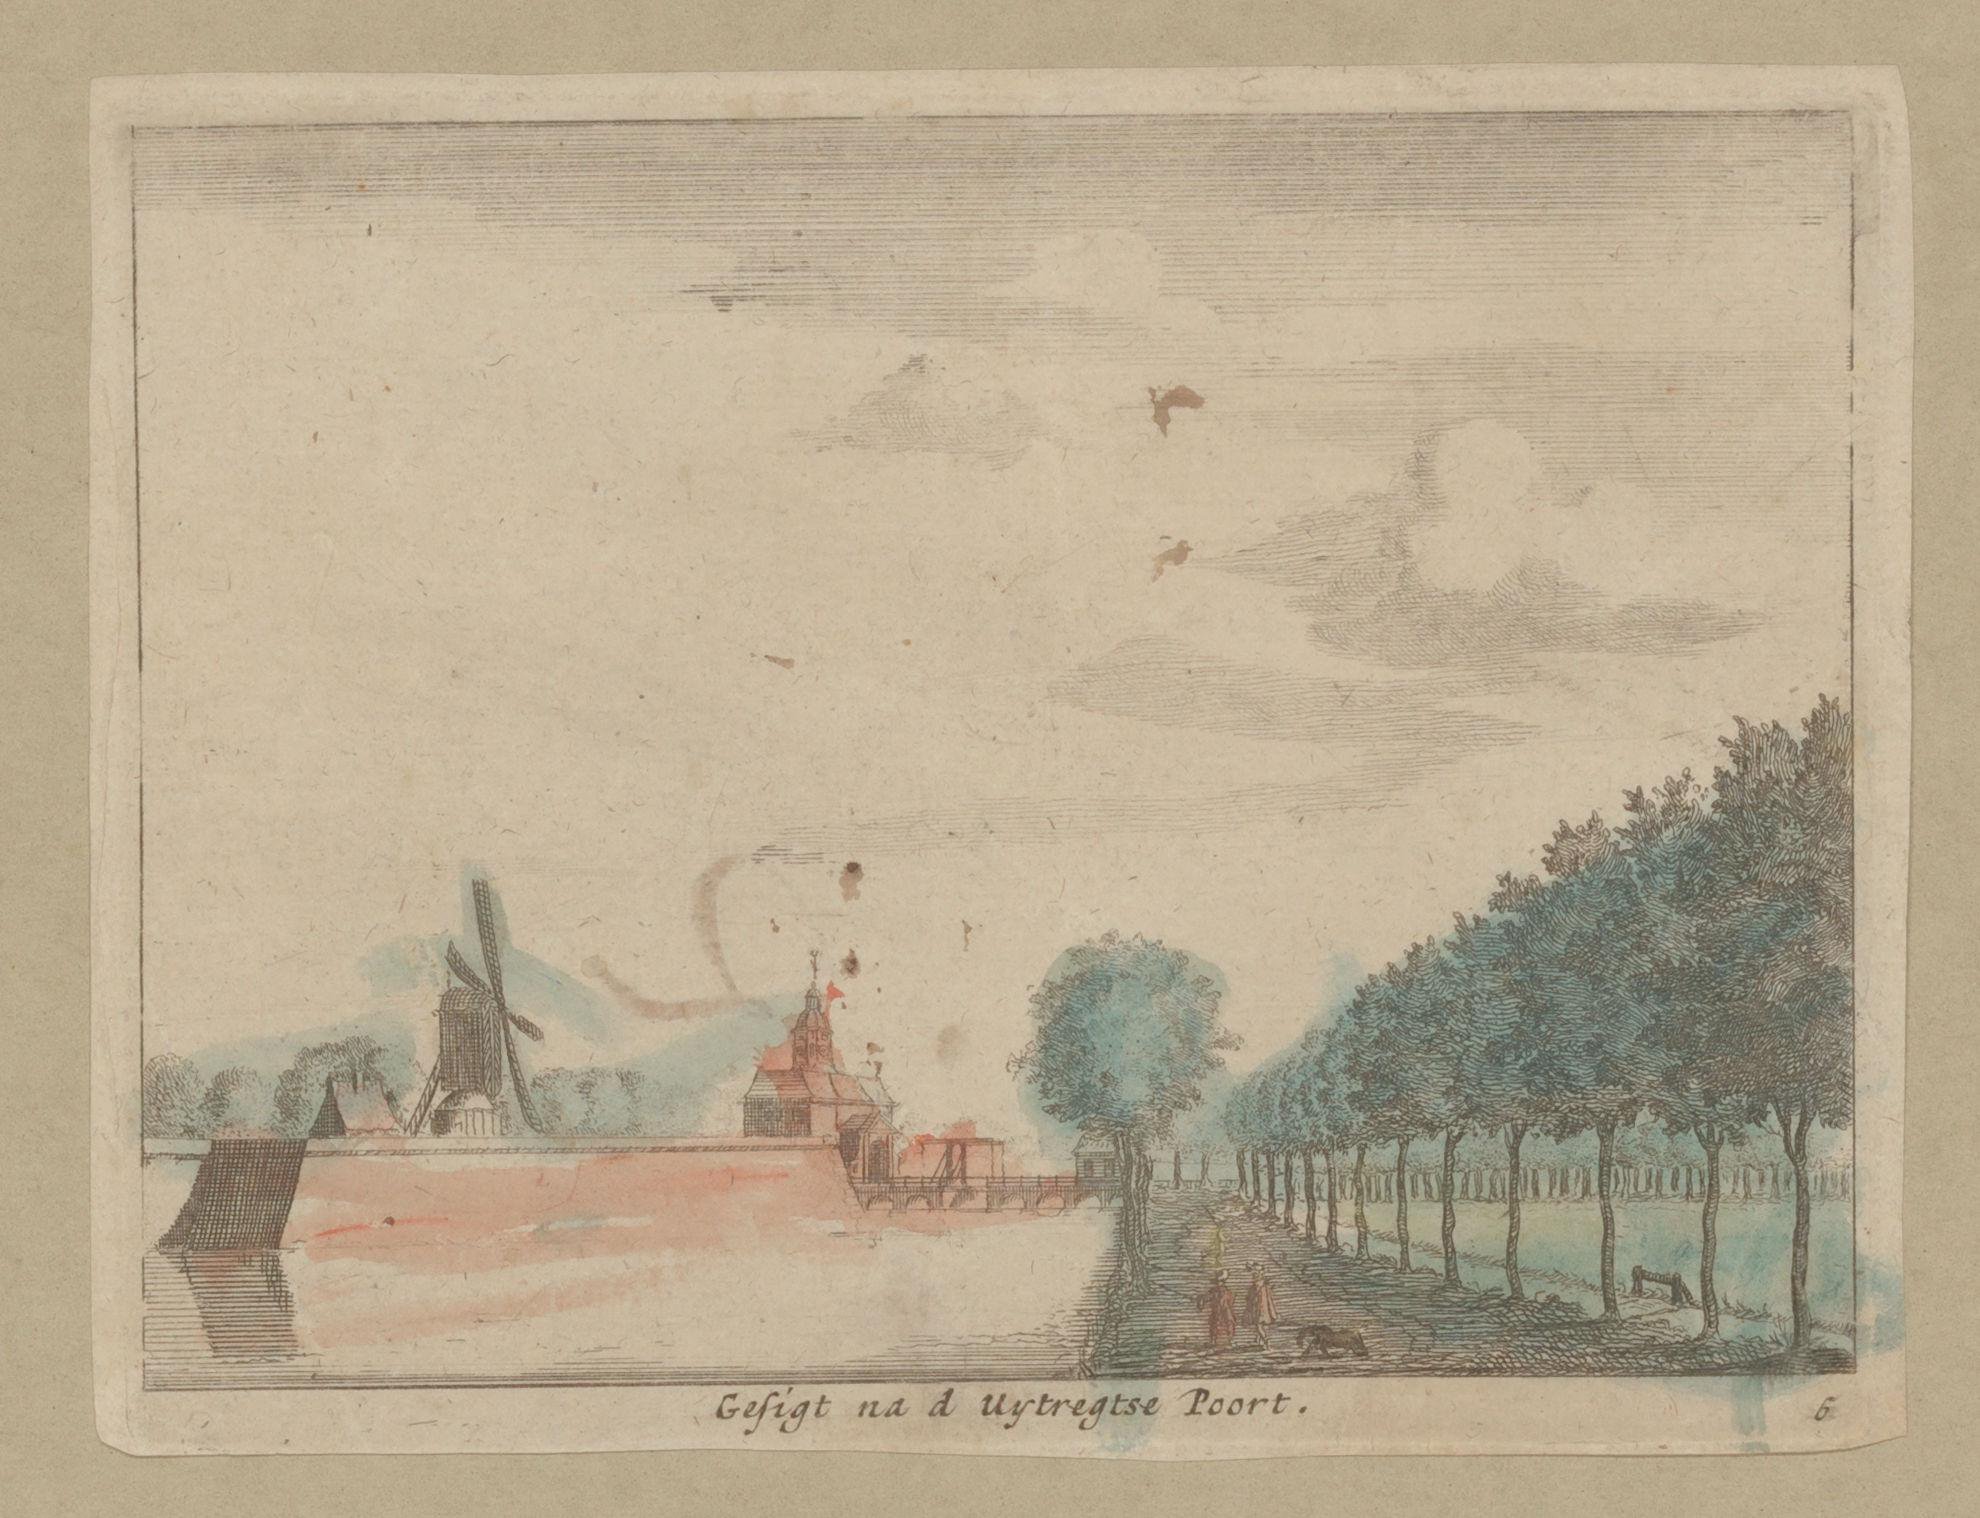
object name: print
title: Gesigt na d Uytregtse Poort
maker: gerard valck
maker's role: print maker, publisher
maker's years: 1651-1726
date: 1661-1726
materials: paper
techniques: engraving, etching, hand coloring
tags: city-gate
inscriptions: collector's mark: Lugt 1641b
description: Rechtsonder genummerd: 6. Onderwerpsrubriek binnen de Atlas Amsterdam: Poorten, verzamelbladen, C. Utrechtse Poort.